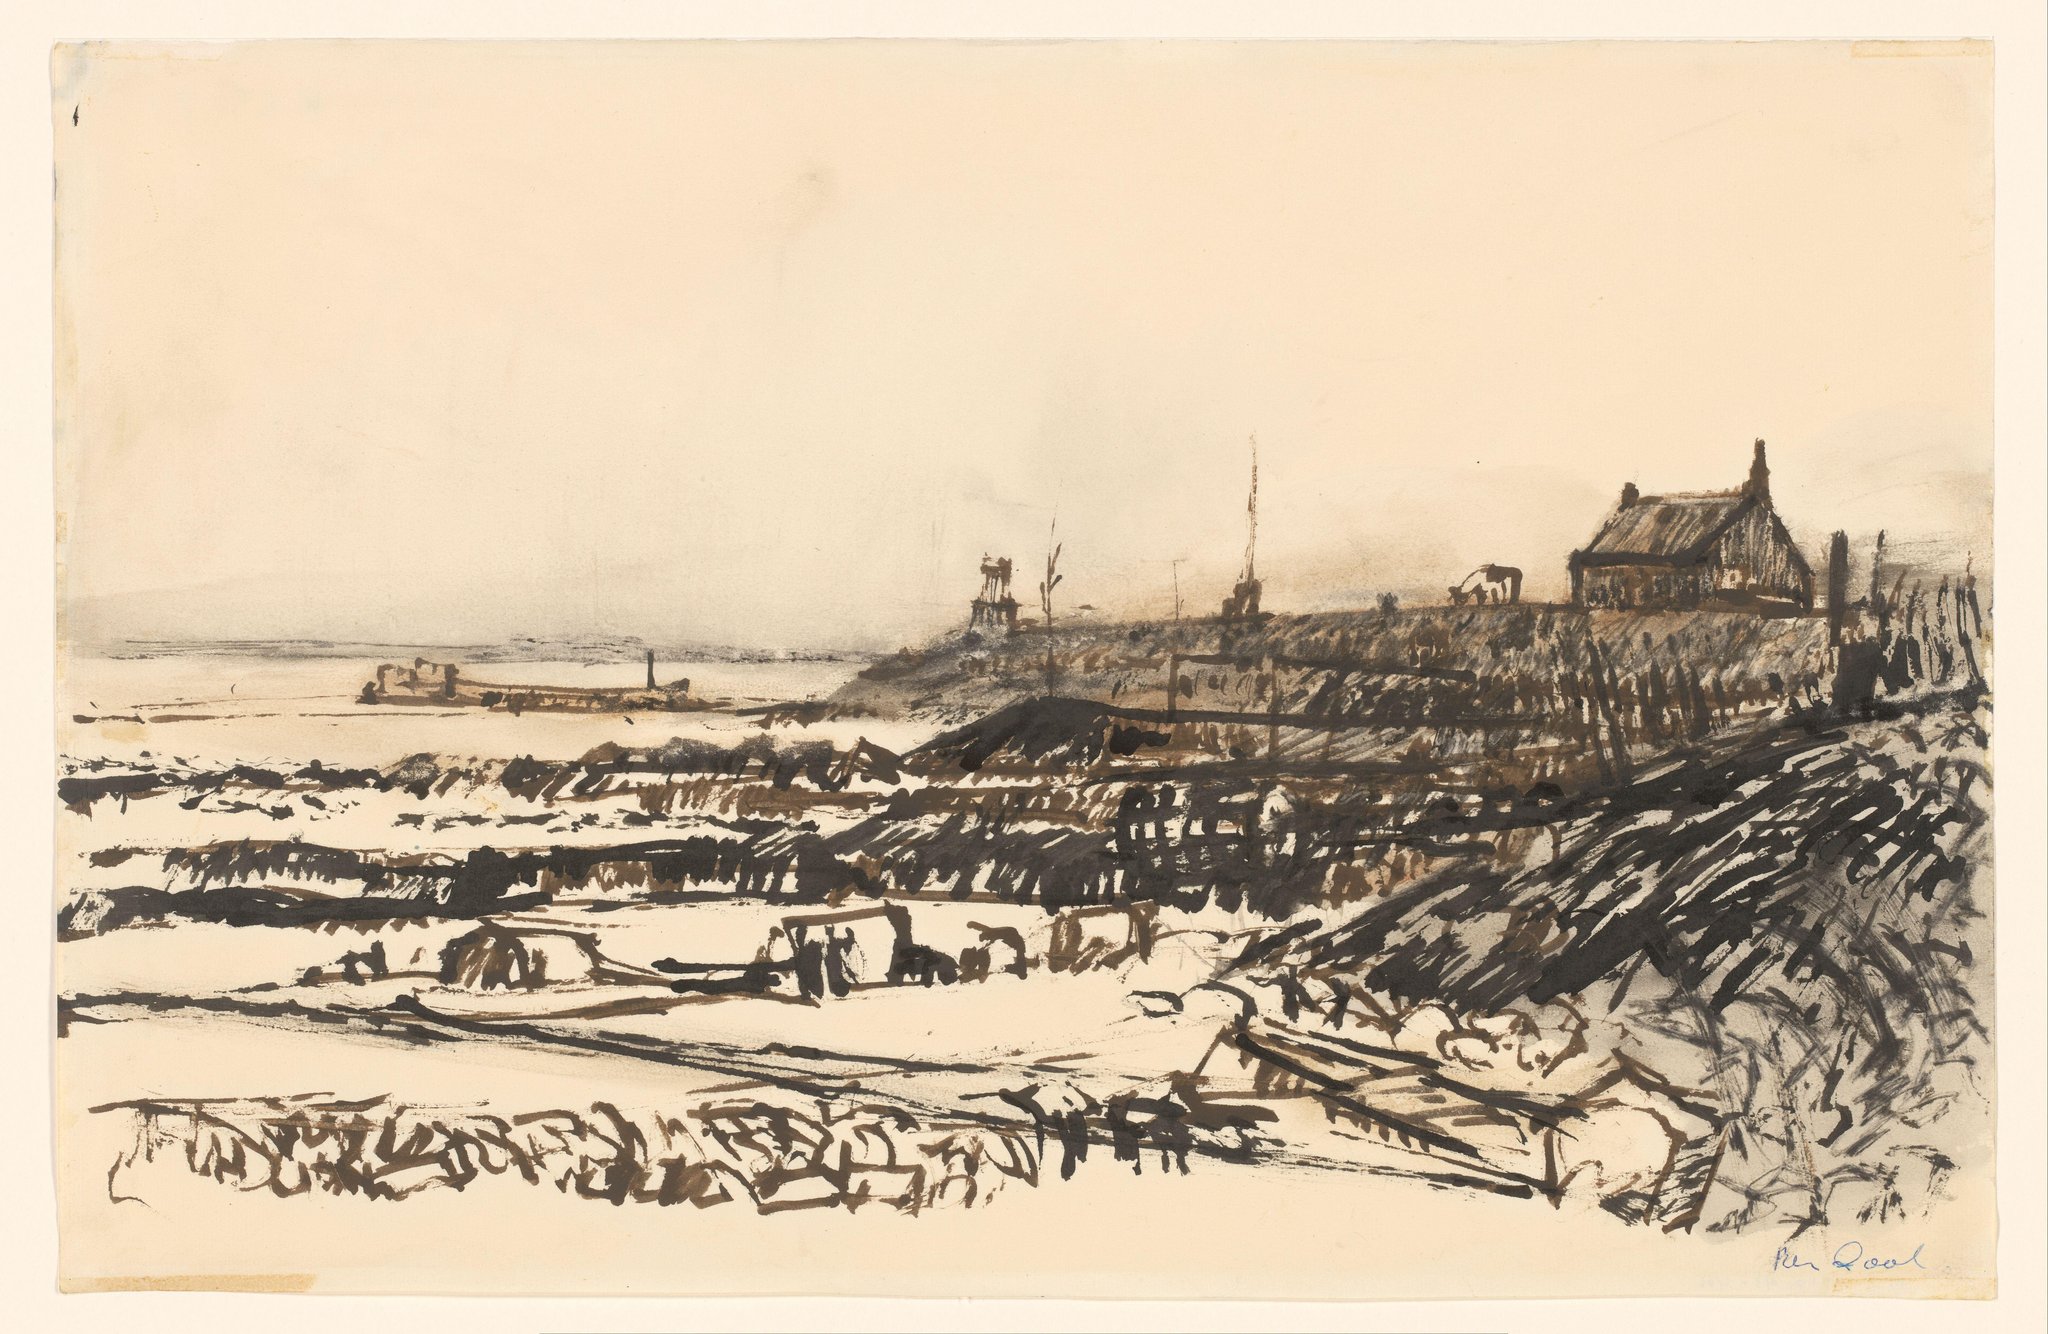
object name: drawing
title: Mosselputten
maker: rein dool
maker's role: draughtsman, painter, print maker, sculptor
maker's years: 1933-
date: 1972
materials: ink, paper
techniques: brush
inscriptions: signature and date: ‘Rein Dool’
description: Gebied met rechts aan de horizon een gebouw met puntdak.